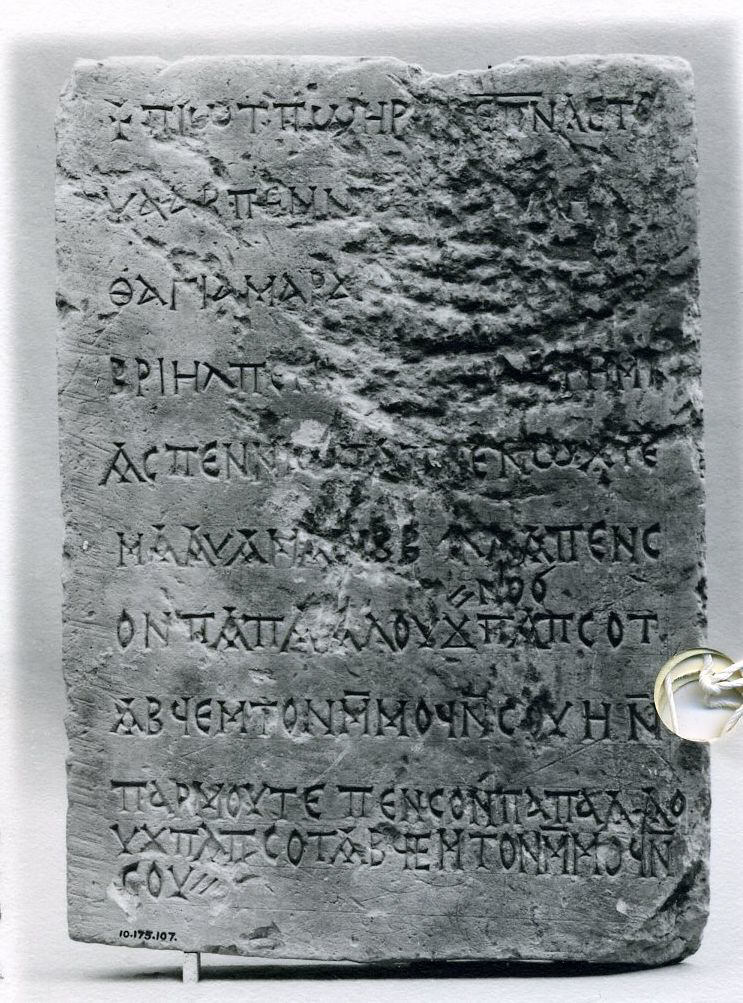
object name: stele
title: Inscribed Stele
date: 501-700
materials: limestone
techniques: incising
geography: egypt